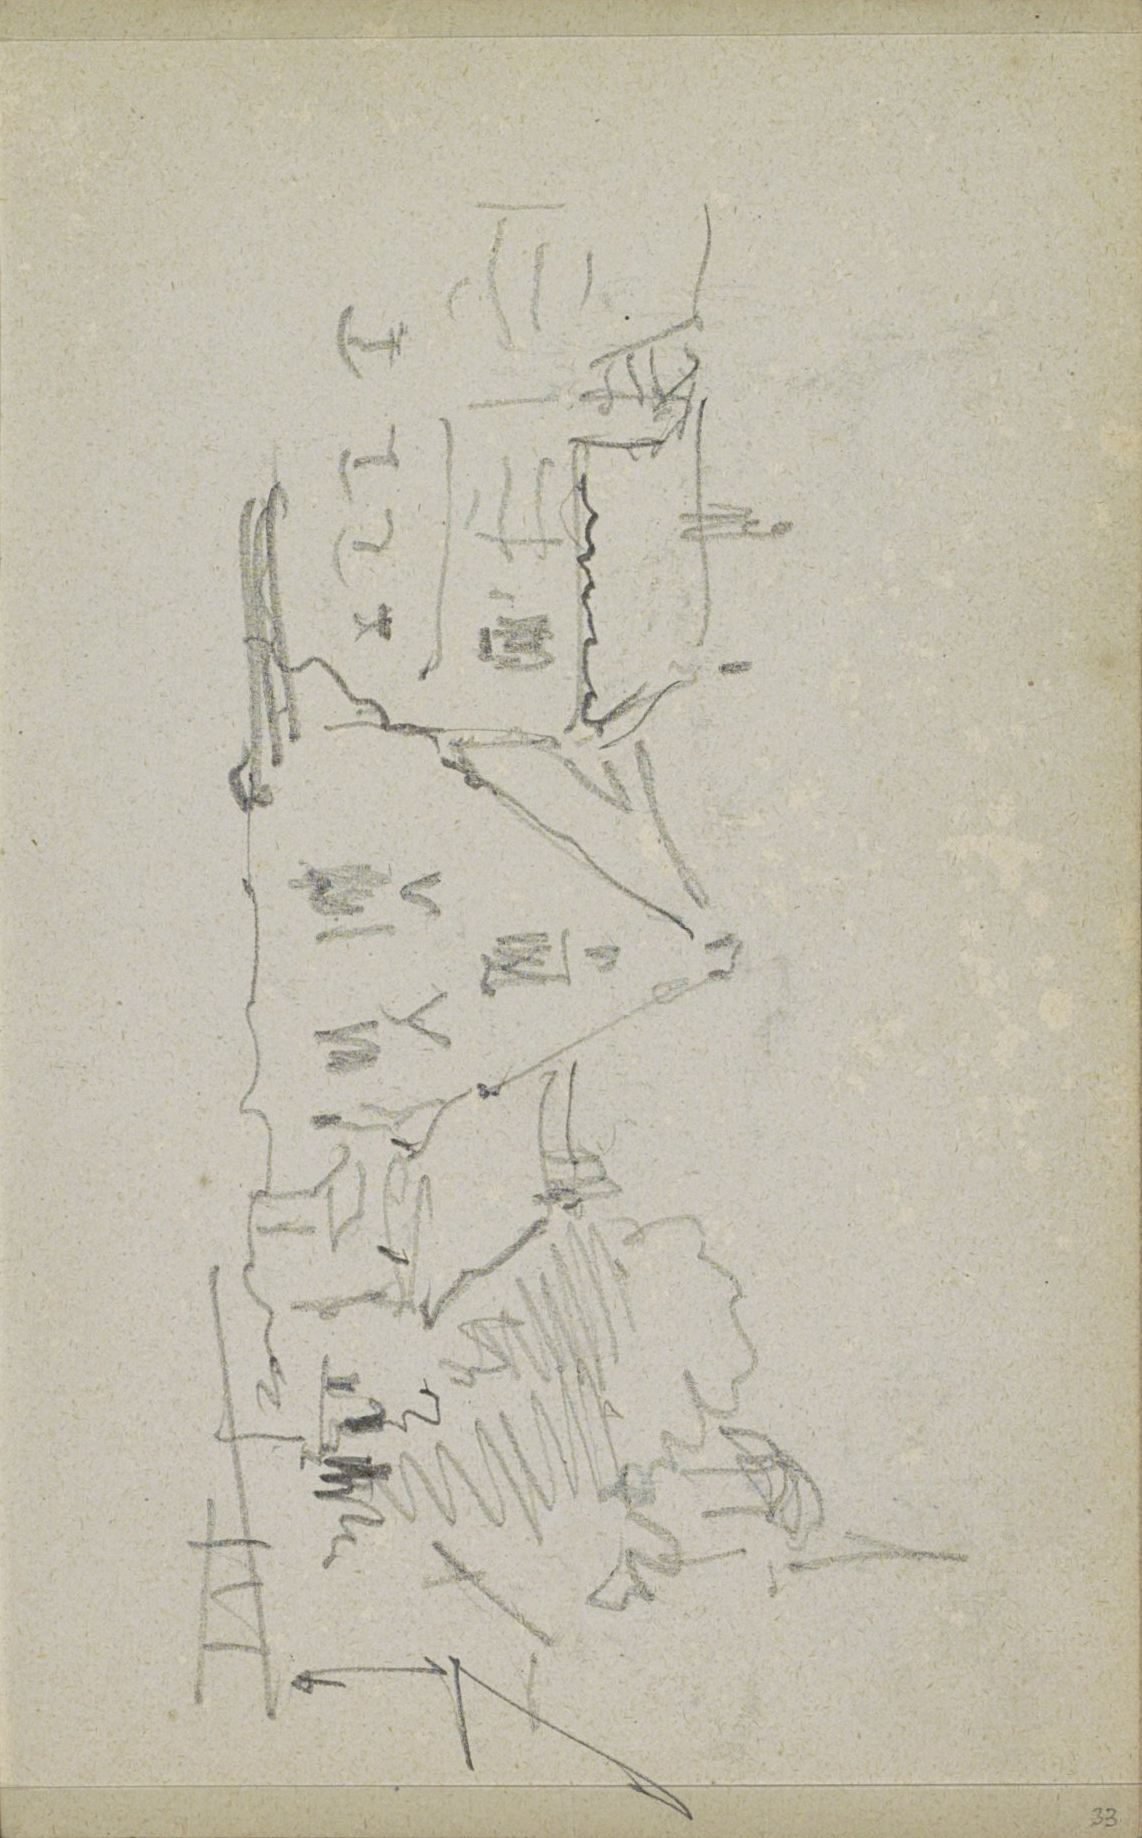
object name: sketchbook leaf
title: Gezicht op een rij huizen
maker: adrianus eversen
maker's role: draughtsman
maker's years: 1818-1897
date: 1828-1897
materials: paper, pencil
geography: netherlands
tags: civic architecture; edifices; dwellings, parts of church exterior and annexes: tower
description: Gezicht op een rij huizen. Rechts een toren, waarschijnlijk een kerktoren. Blad 33 recto uit een schetsboek met 58 bladen.